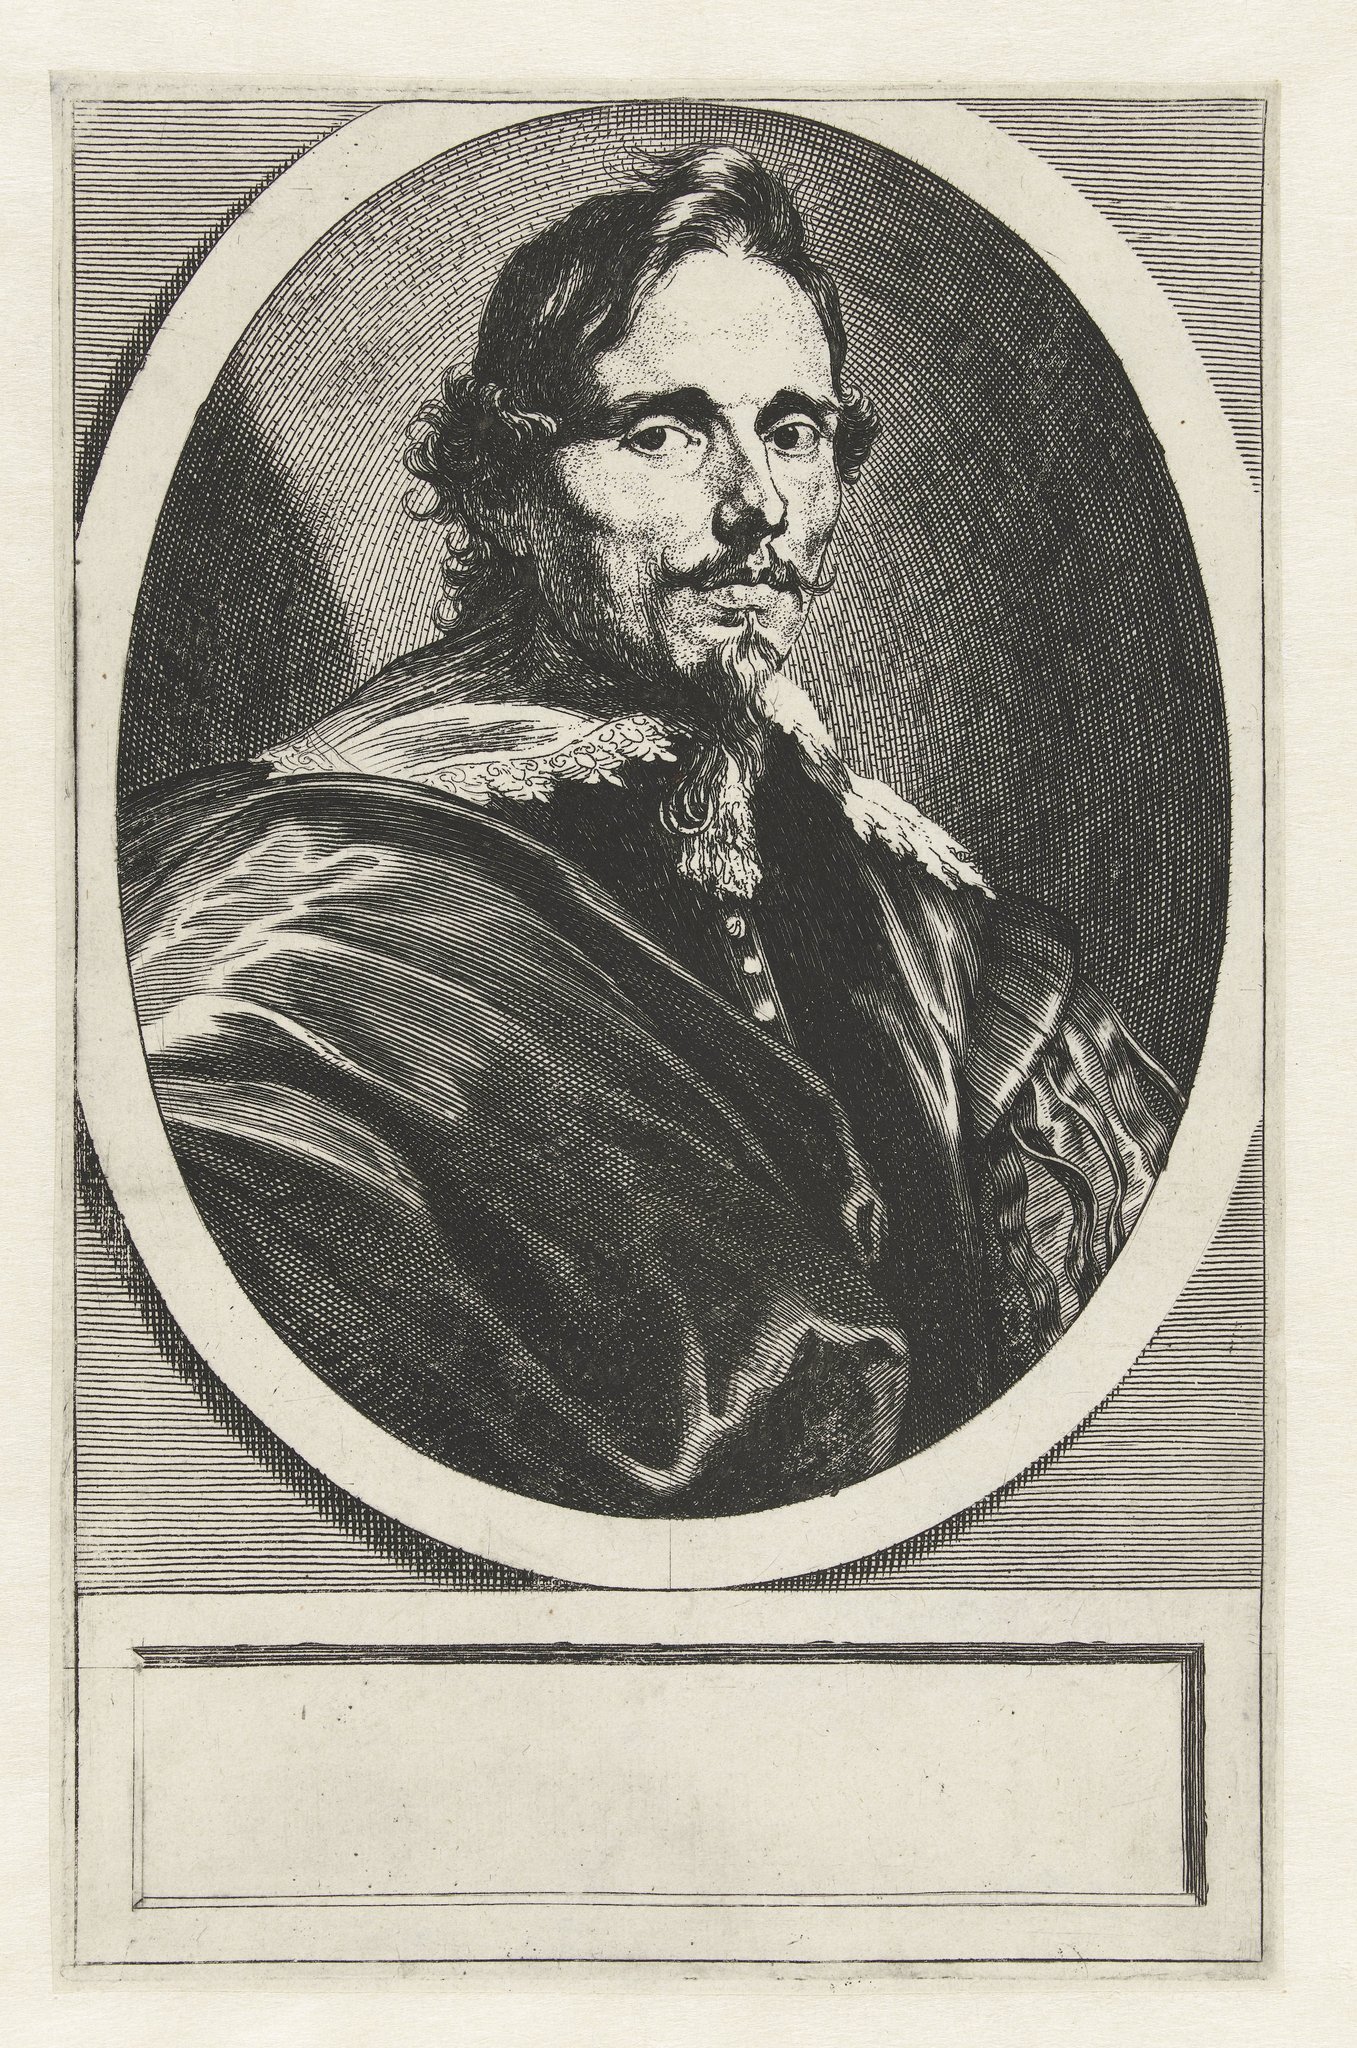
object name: print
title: Portret van de verzamelaar en diplomaat Philippe Le Roy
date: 1630-1632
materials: paper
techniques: engraving, etching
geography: low countries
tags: art collector, diplomacy, diplomat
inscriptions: collector's mark: Lugt 240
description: Portret van de kunstverzamelaar en diplomaat Philippe Le Roy, Heer van Ravels, baron van Broechem, raadsheer van koning Filips IV van Spanje